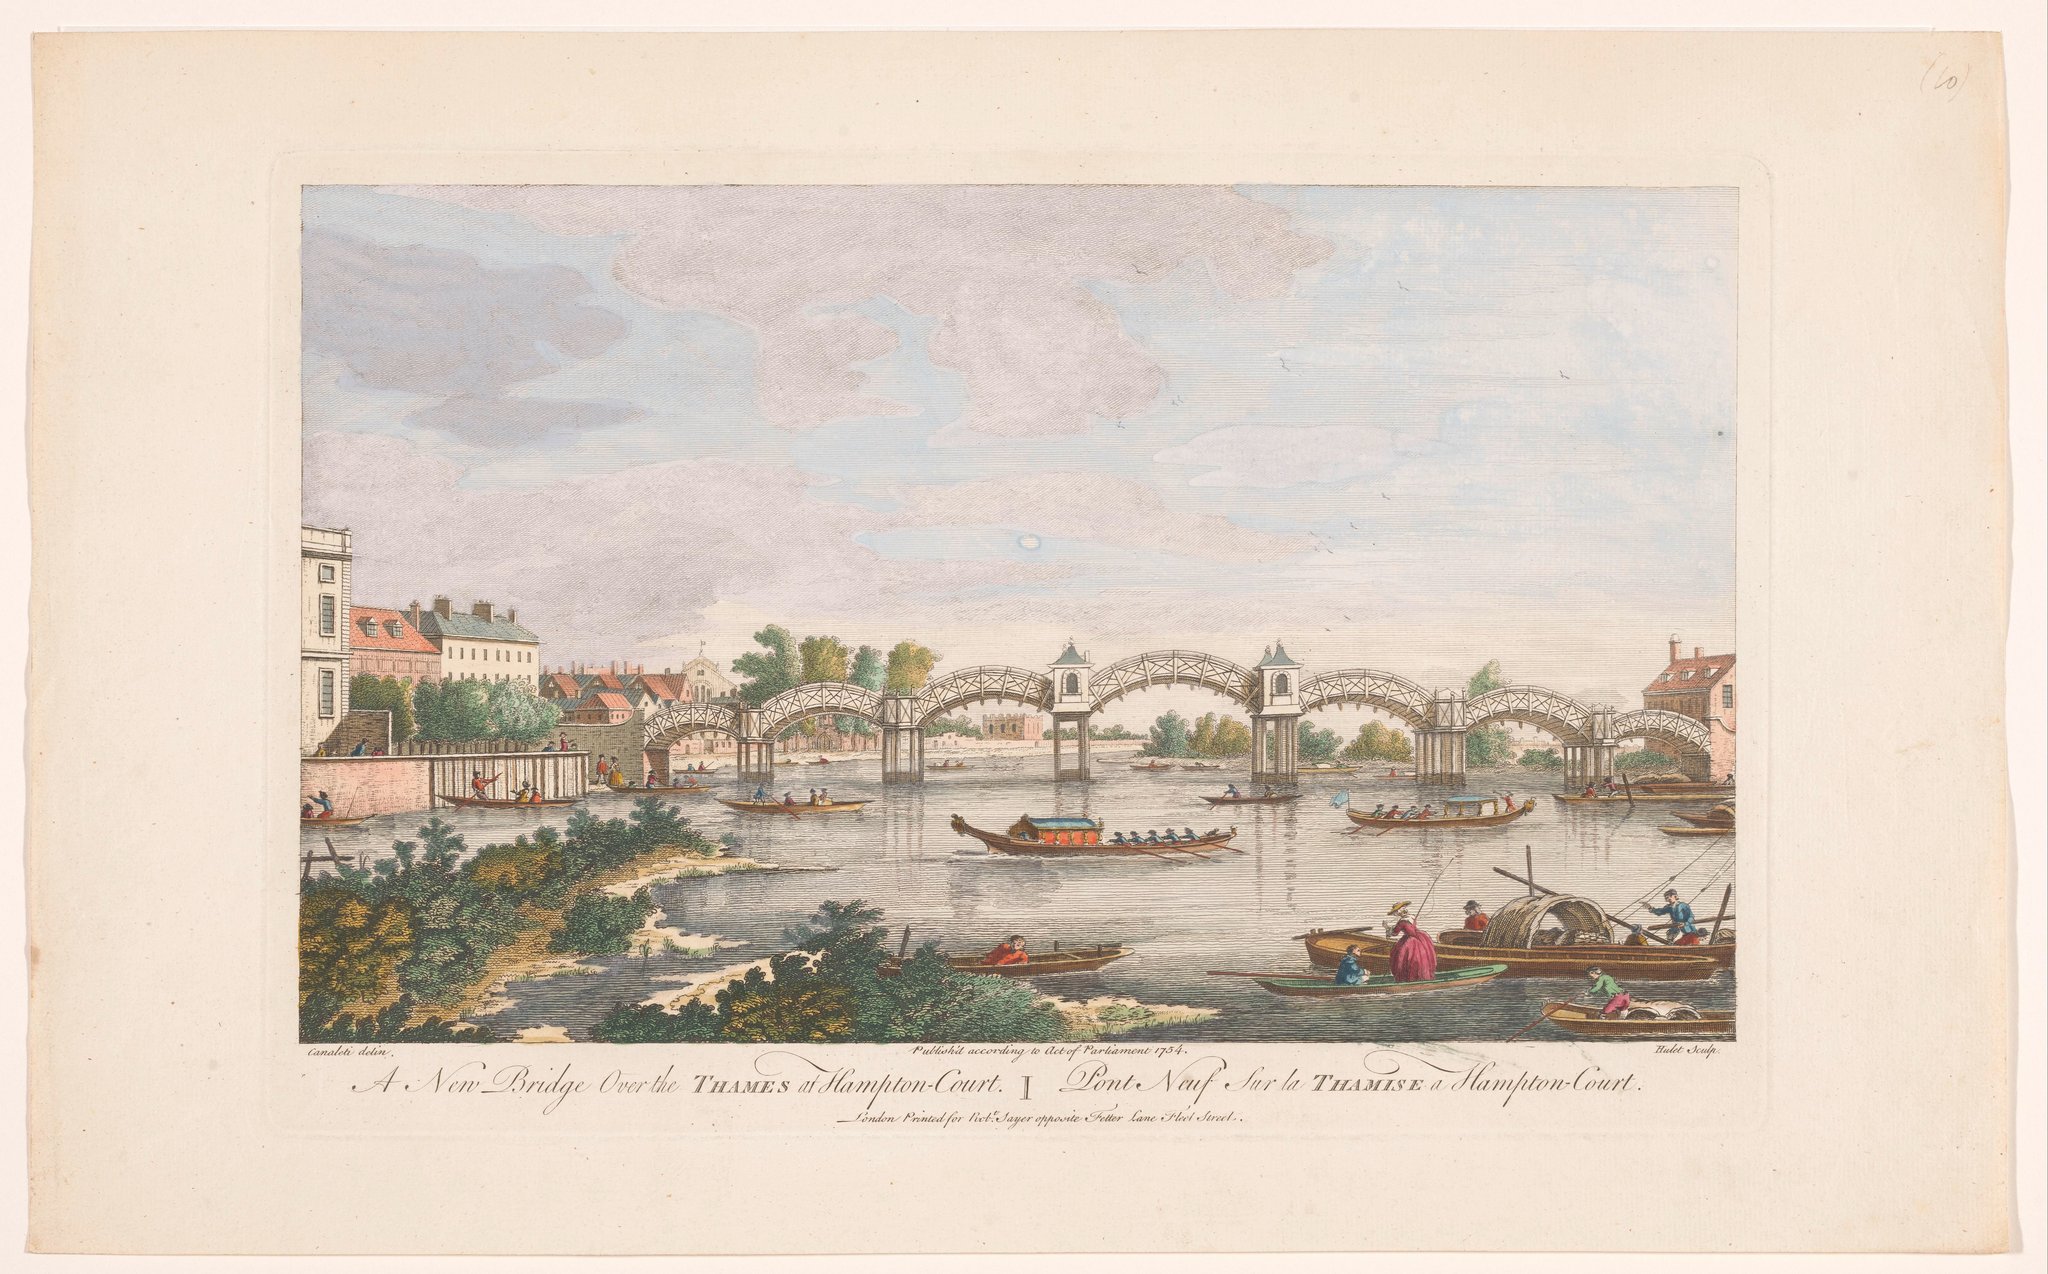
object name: opticaprent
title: Gezicht op de Hampton Court Bridge over de rivier de Theems tussen Hampton en East Molesey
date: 1754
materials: paper, watercolor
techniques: brush, etching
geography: england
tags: bridge in city across river, canal, etc. (+ city(-scape) with figures, staffage), rowing-boat, canoe, etc., thames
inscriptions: watermark